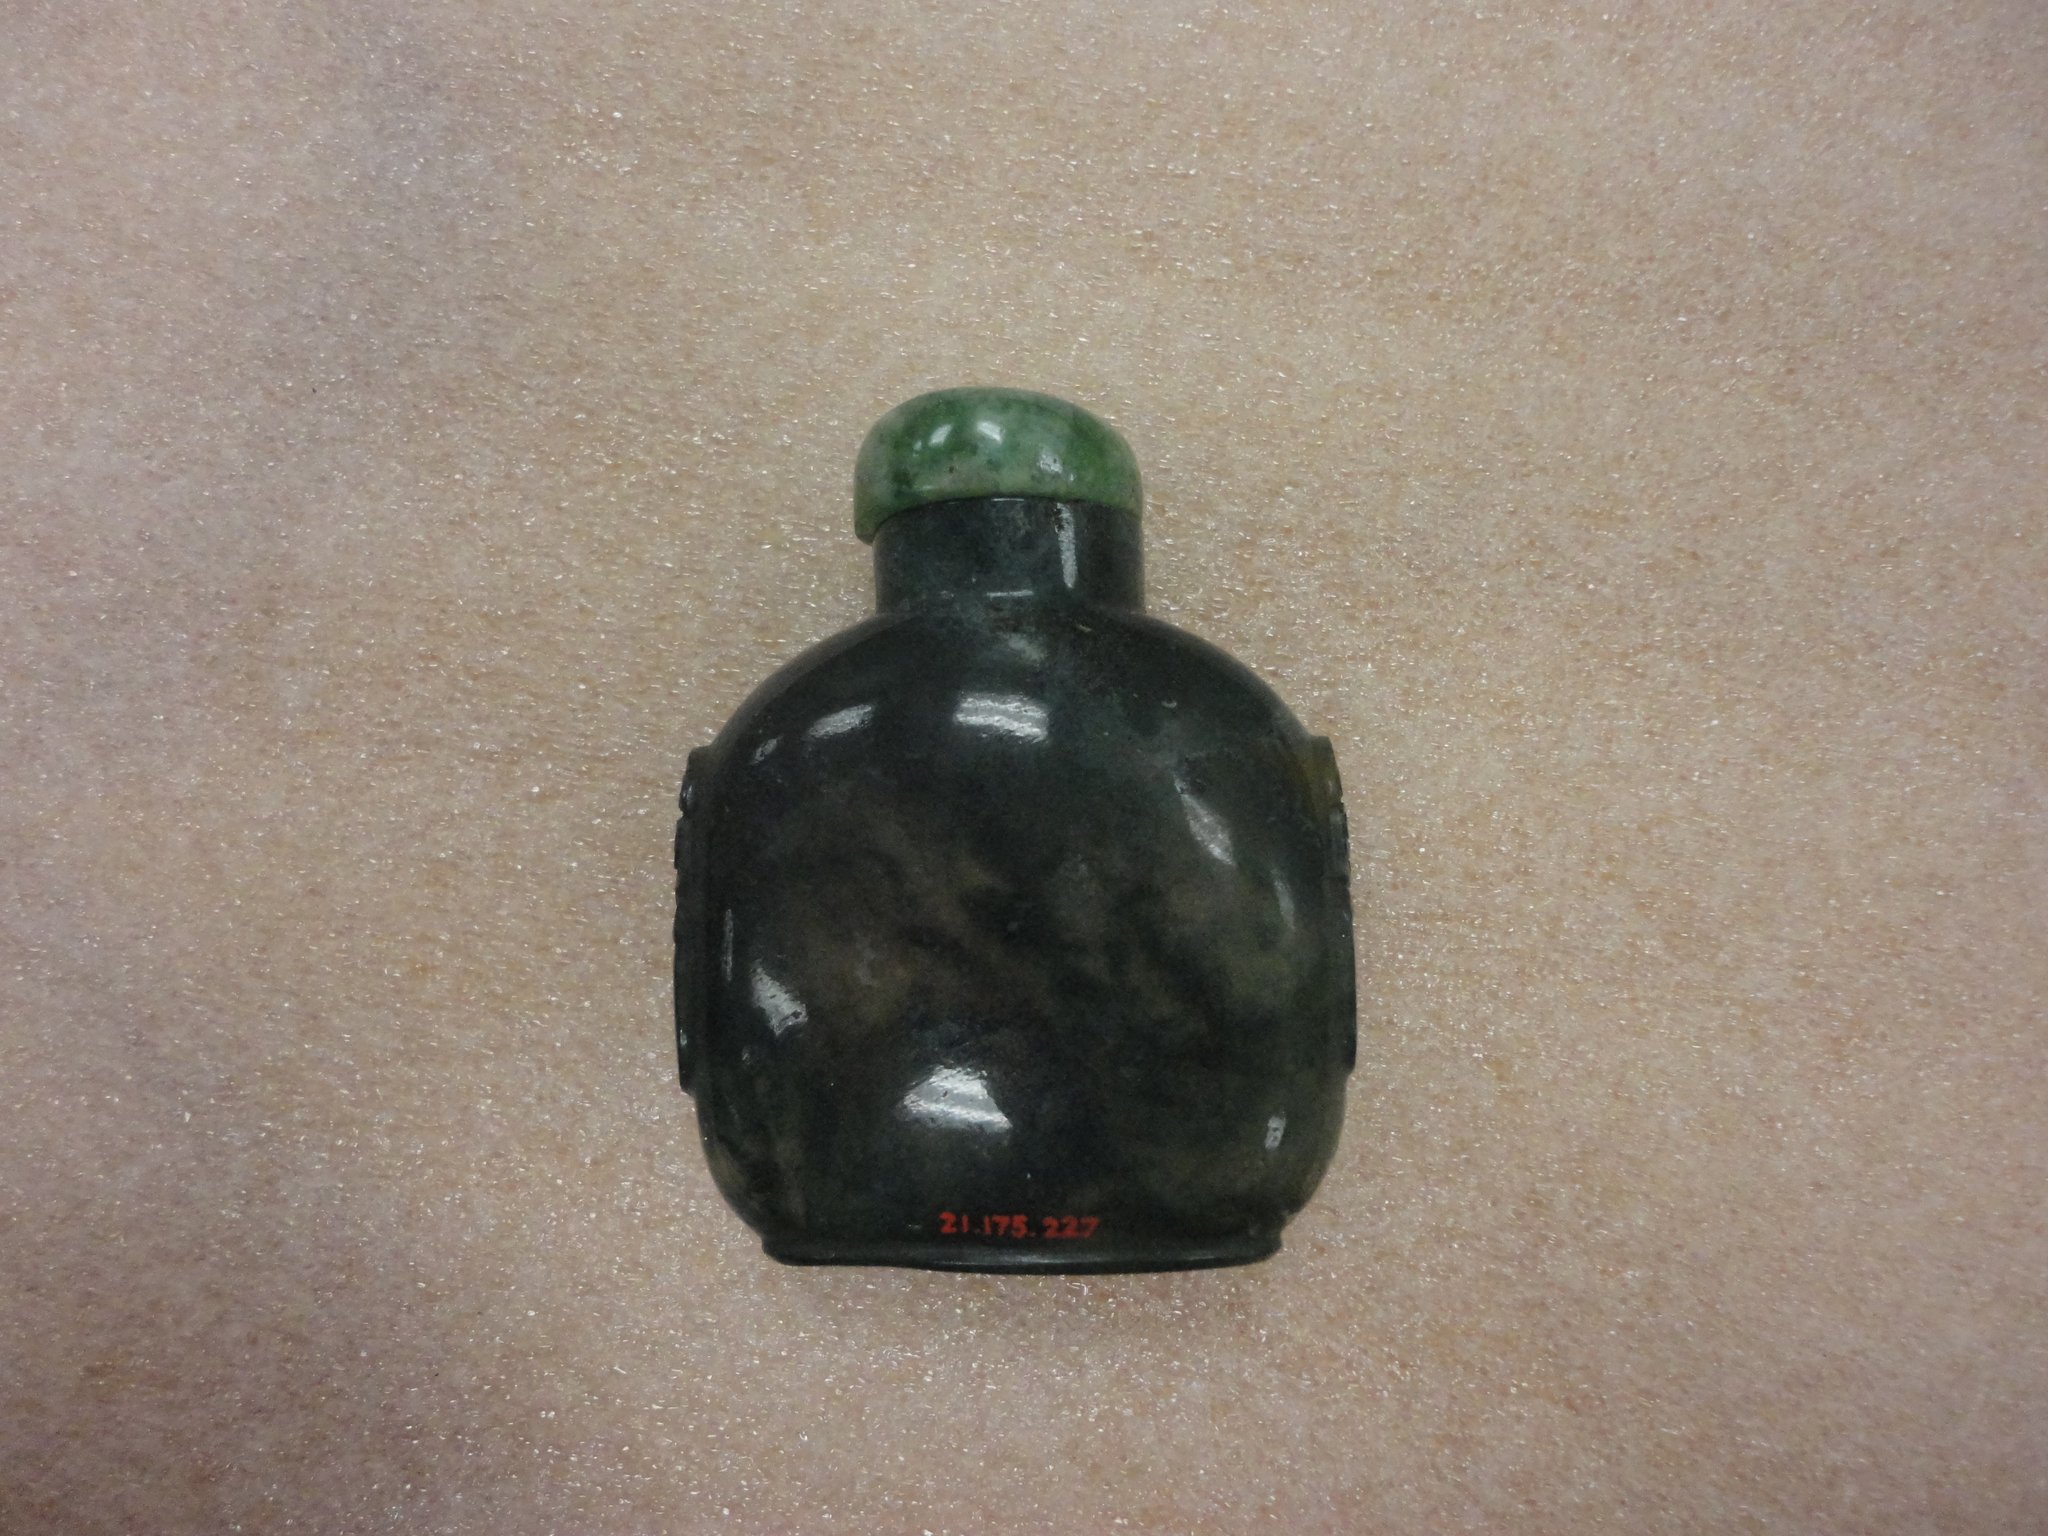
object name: snuff bottle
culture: chinese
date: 1736-1795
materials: stone, jade